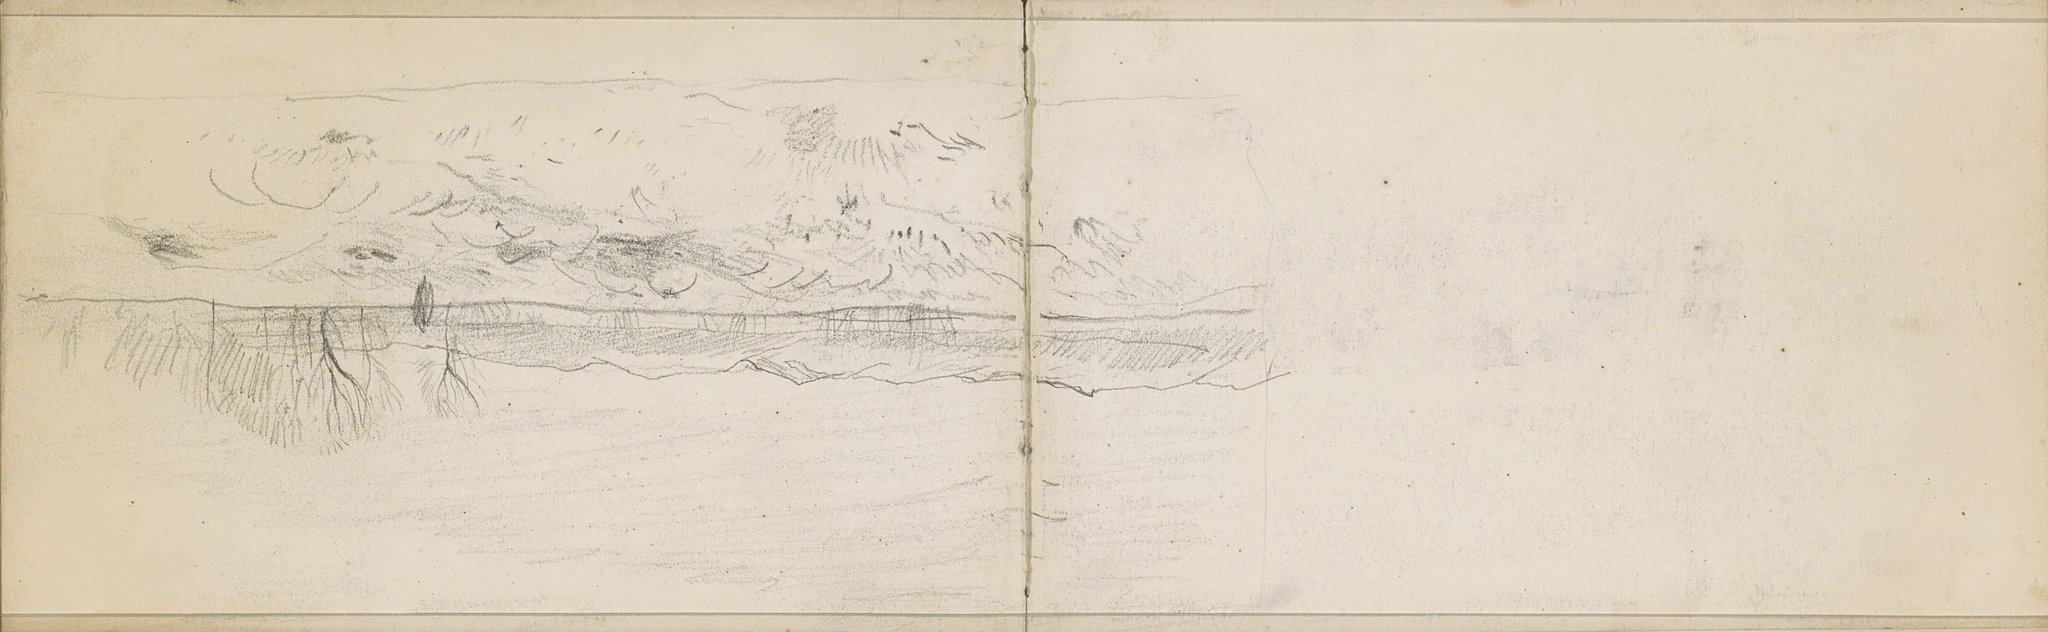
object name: sketchbook leaf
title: Heuvellandschap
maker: anton mauve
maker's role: draughtsman, painter, print maker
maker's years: 1838-1888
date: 1848-1888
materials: paper, pencil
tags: low hill country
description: Blad 42 verso en 43 recto uit een schetsboek met 44 bladen.